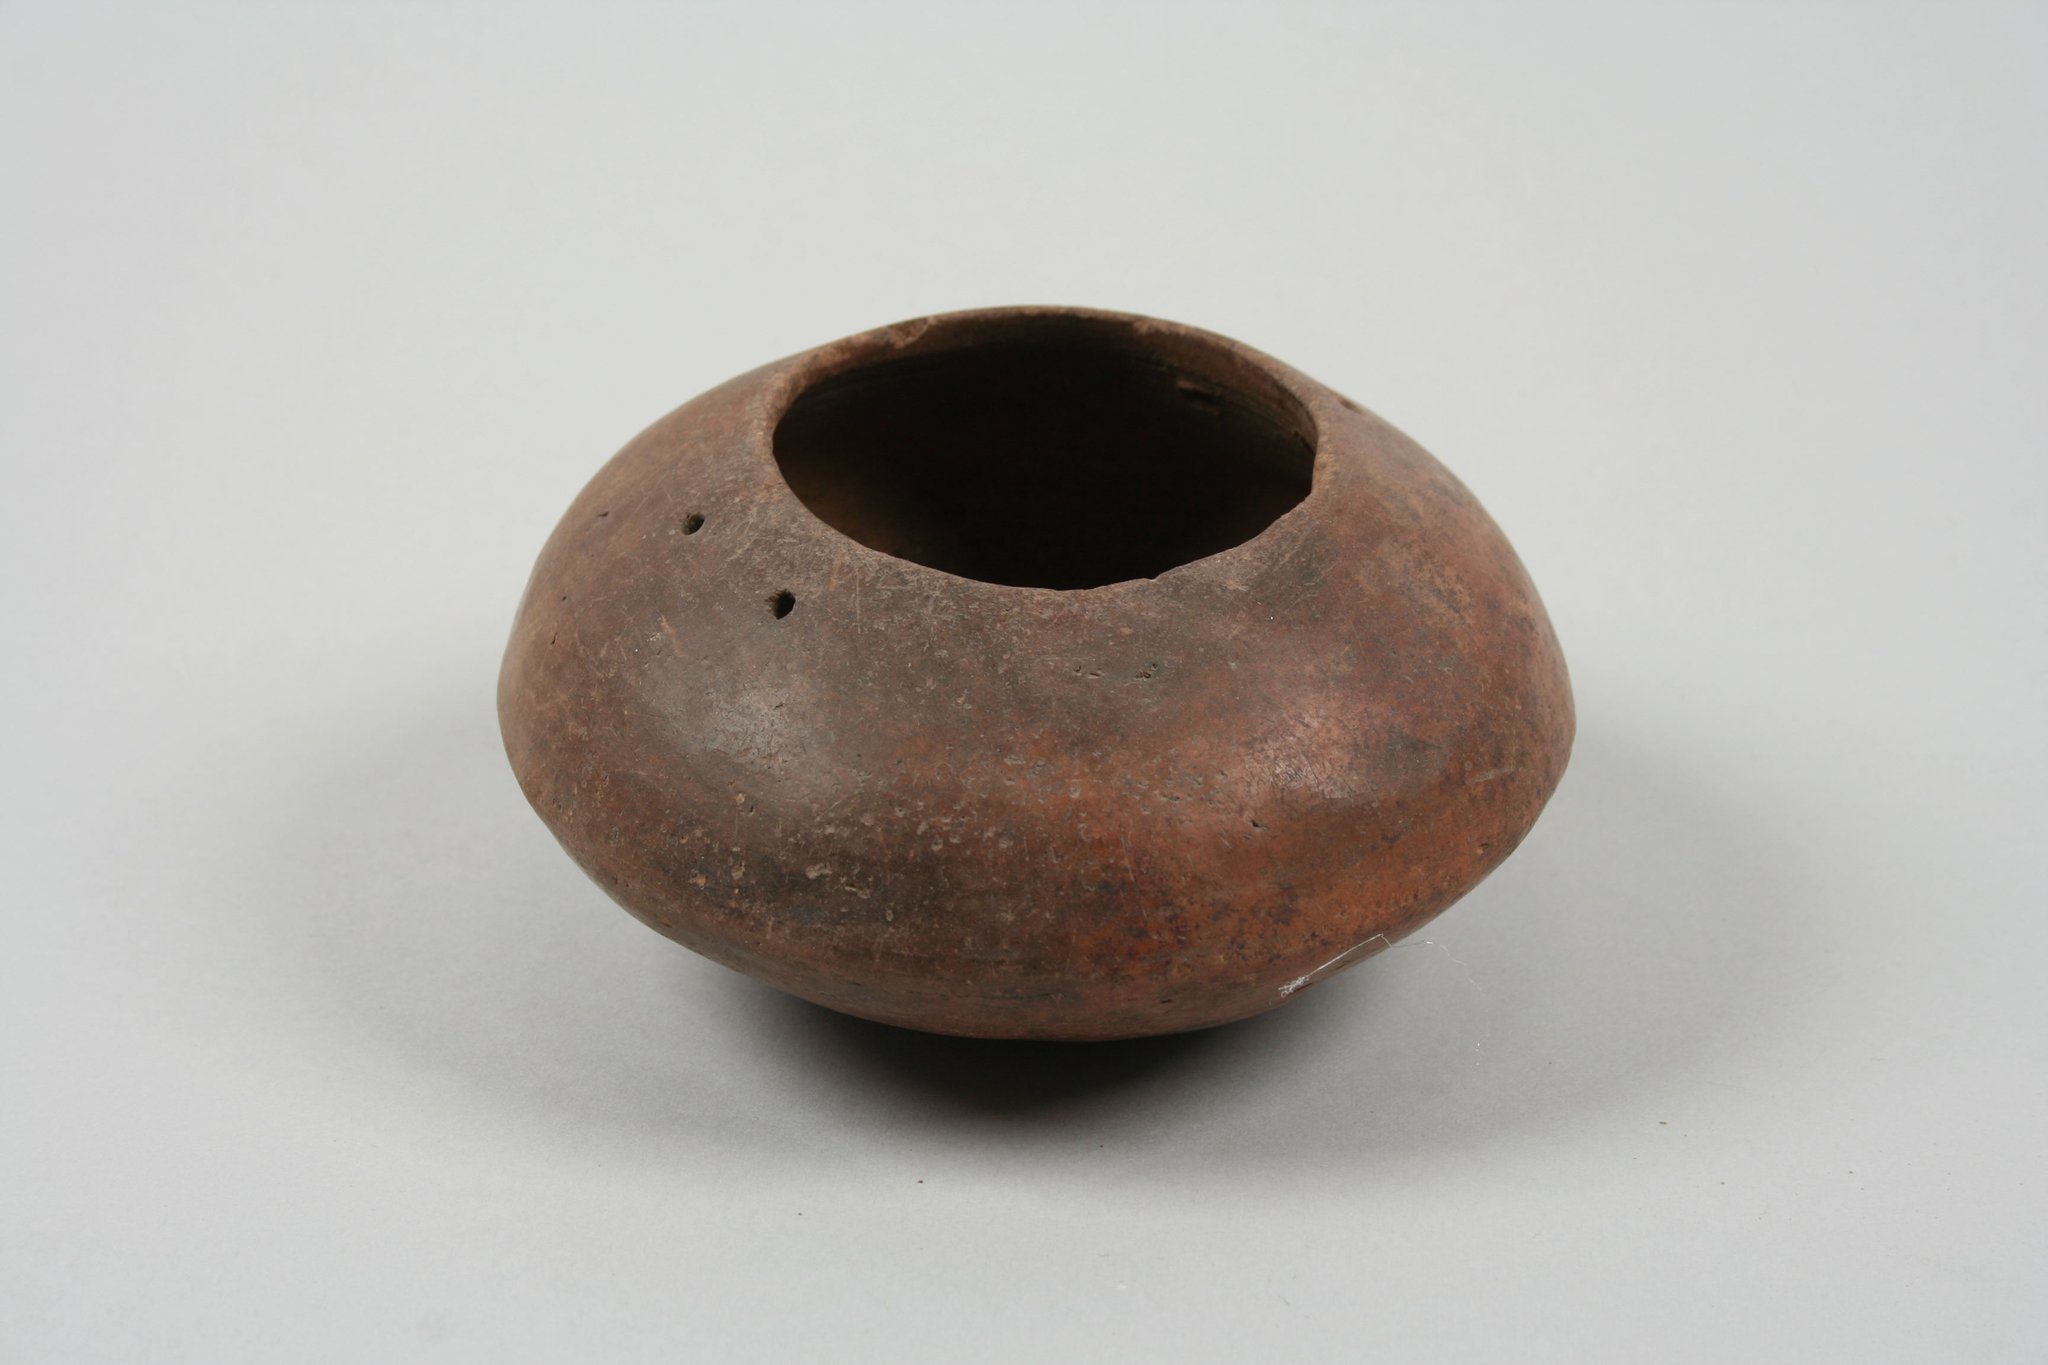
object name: bowl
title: Undecorated lenticular bowl with suspension holes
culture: paracas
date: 400-201 BCE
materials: ceramic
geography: peru